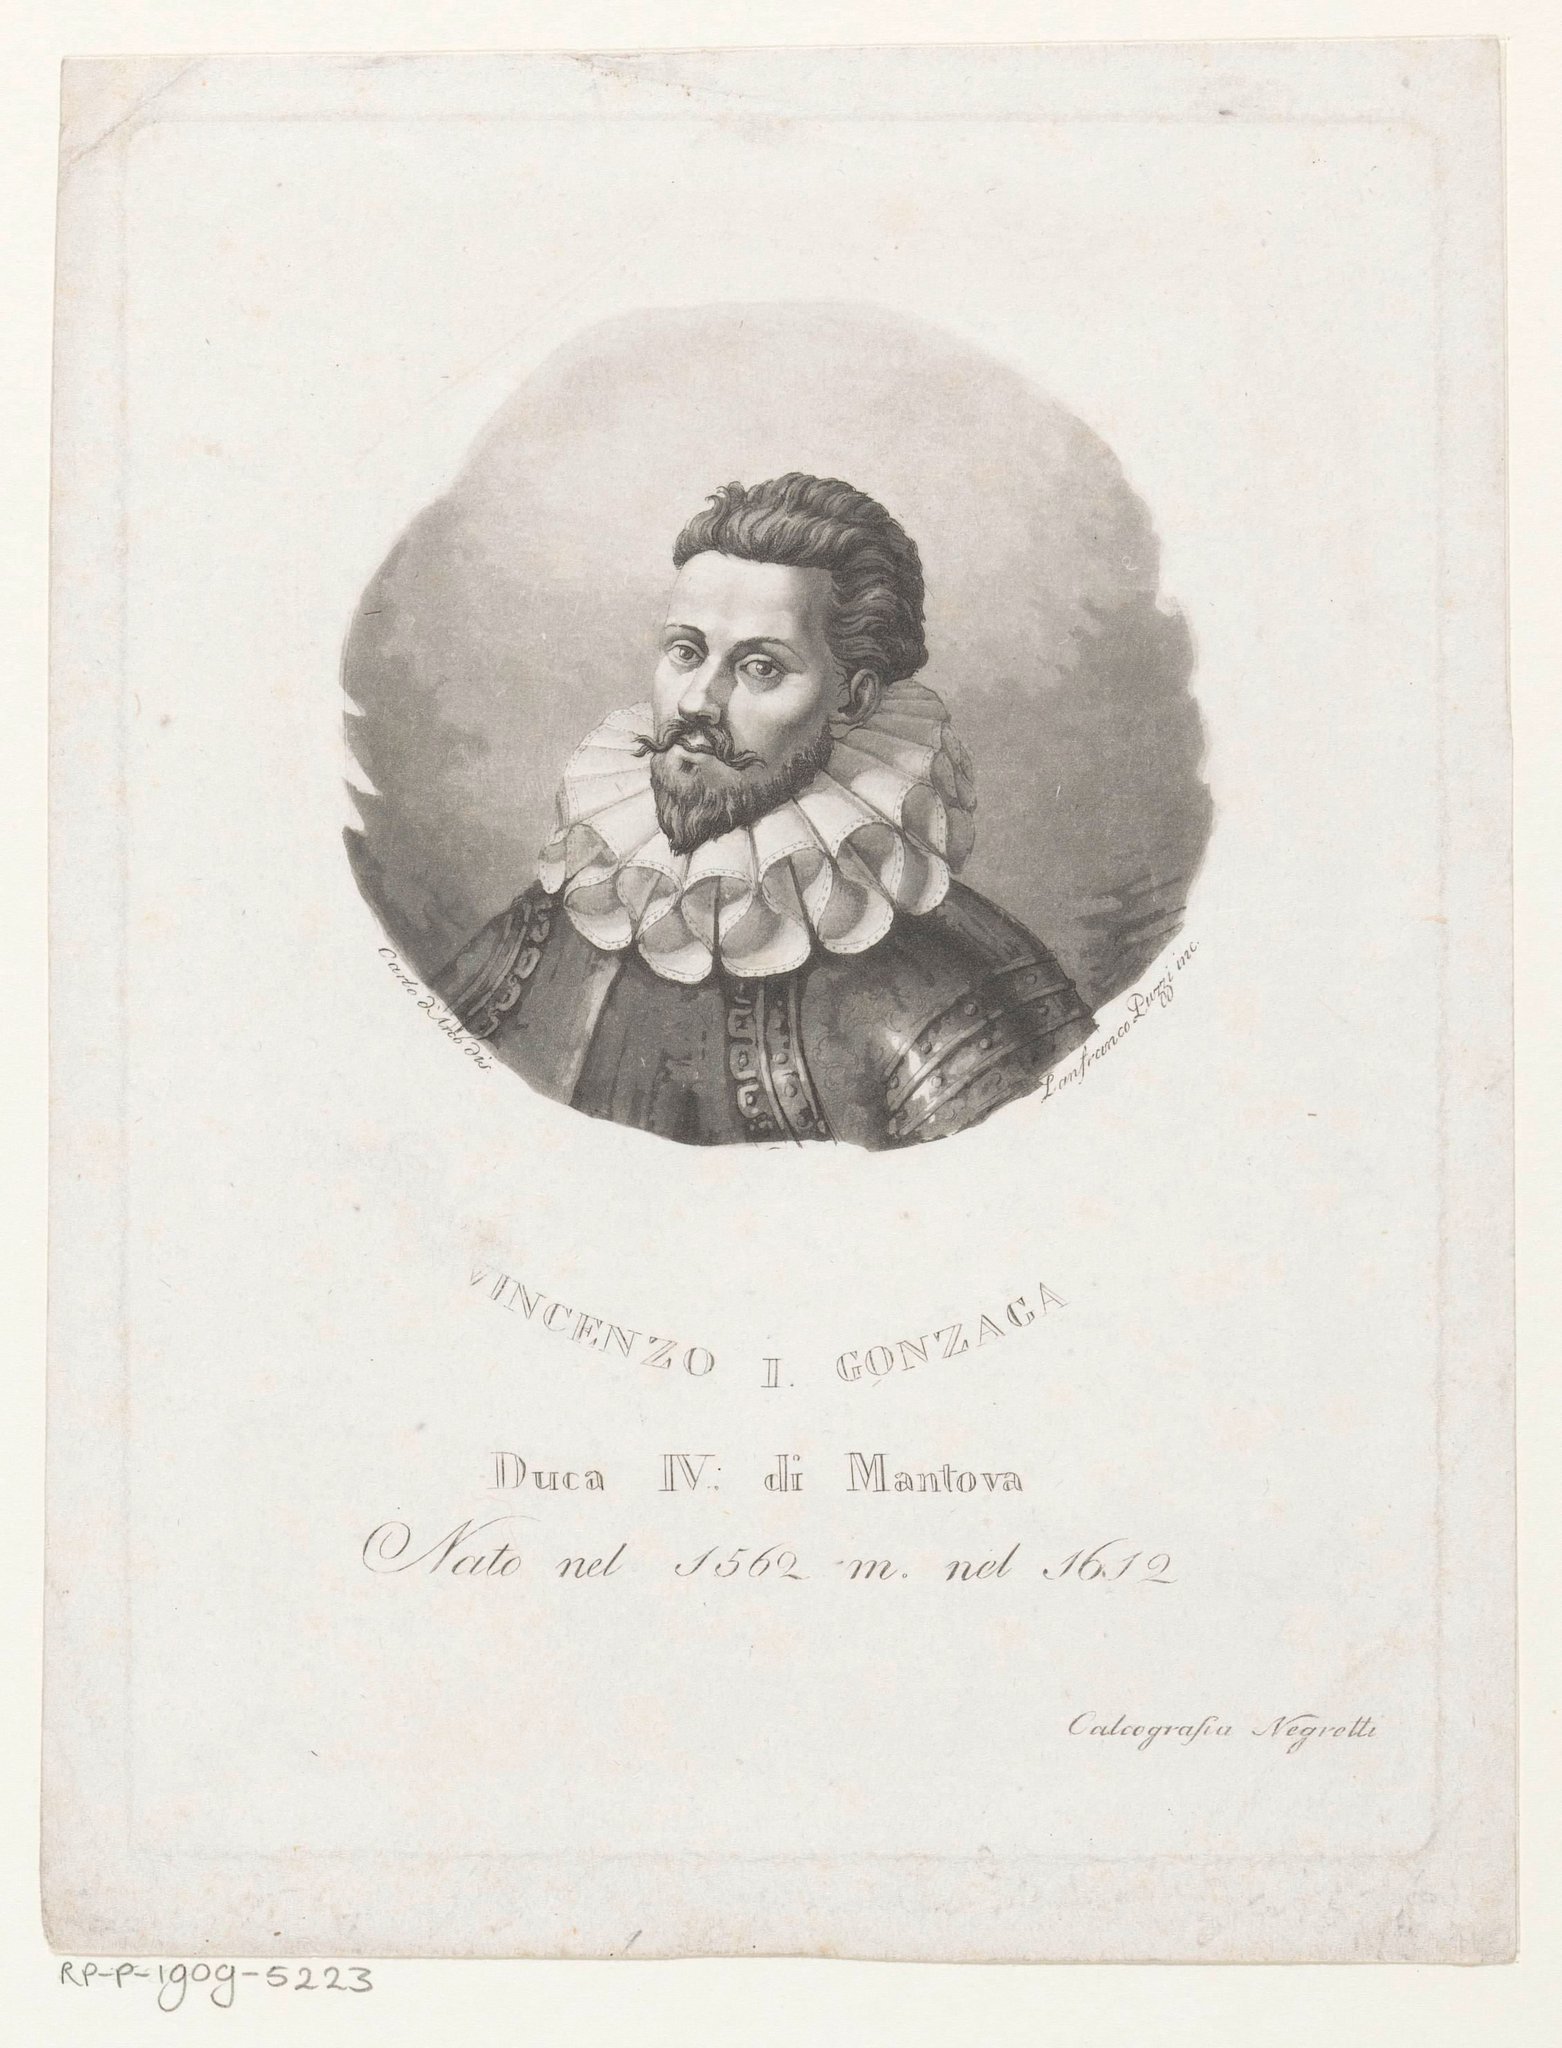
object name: print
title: Portret van Vincenzo I. Gonzaga, hertog van Mantua en Montferrato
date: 1830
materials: paper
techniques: aquatint, etching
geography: italy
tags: vincenzo i. gonzaga (hertog van mantua en montferrato), historical persons, ruler, sovereign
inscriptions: collector's mark: Lugt 2228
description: Deze prent maakt deel uit van een reeks portretprenten.